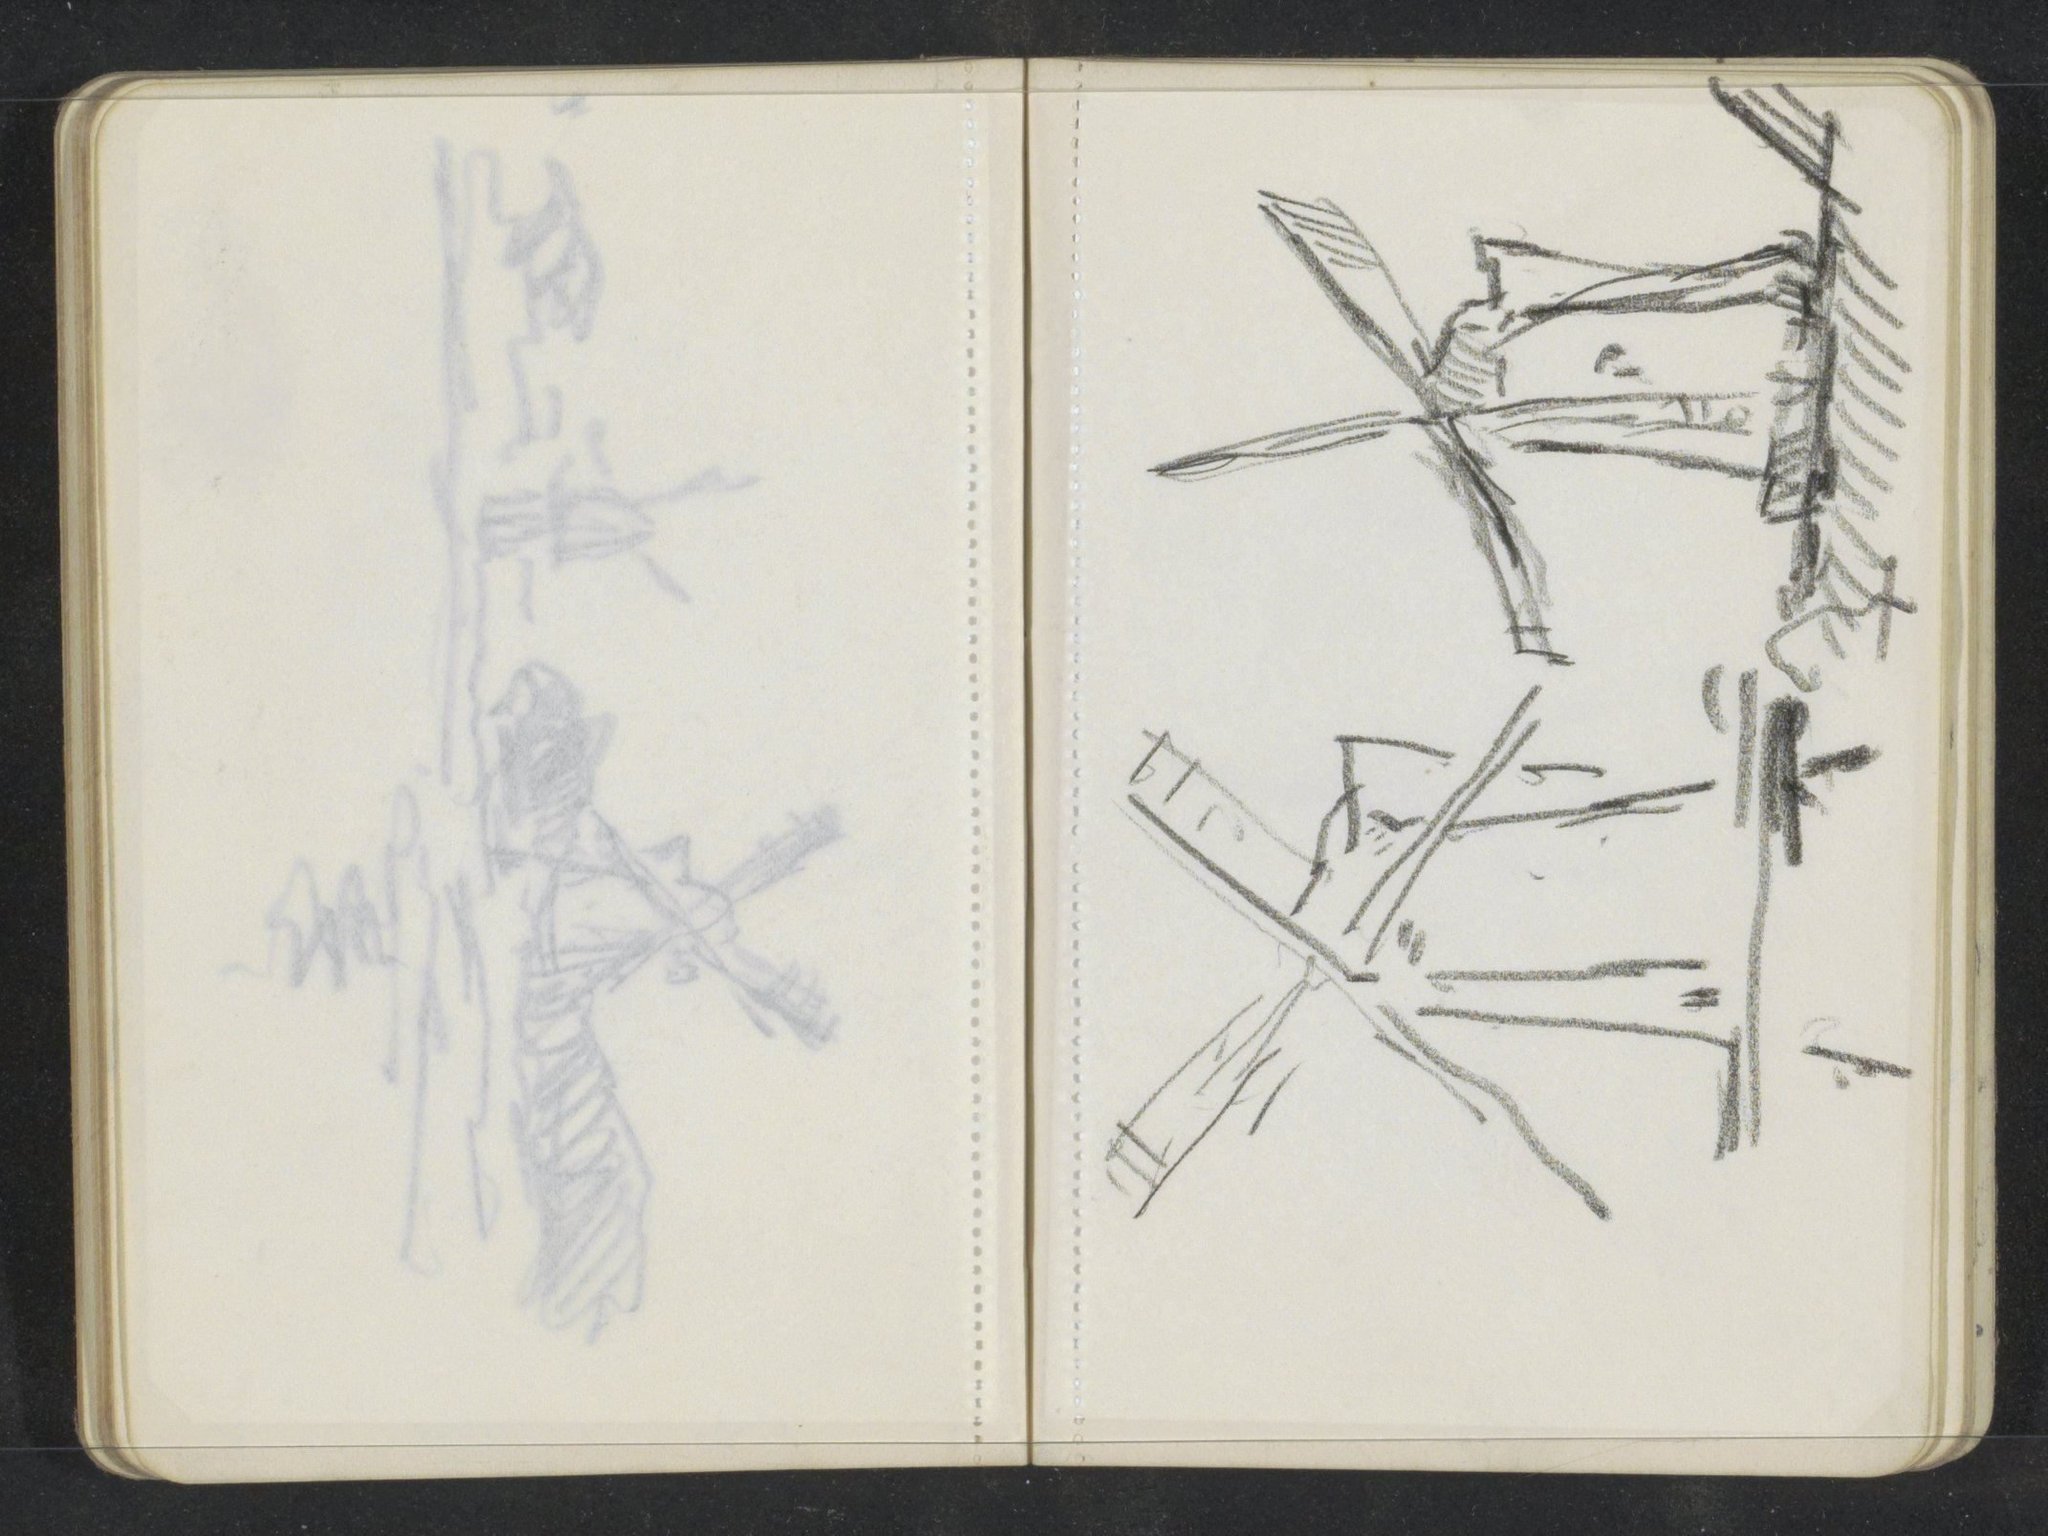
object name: sketchbook leaf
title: Twee molens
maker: alexander shilling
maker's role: draughtsman, print maker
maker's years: 1859-1937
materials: chalk, paper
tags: windmill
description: Blad 41 recto uit een schetsboek met 91 bladen.